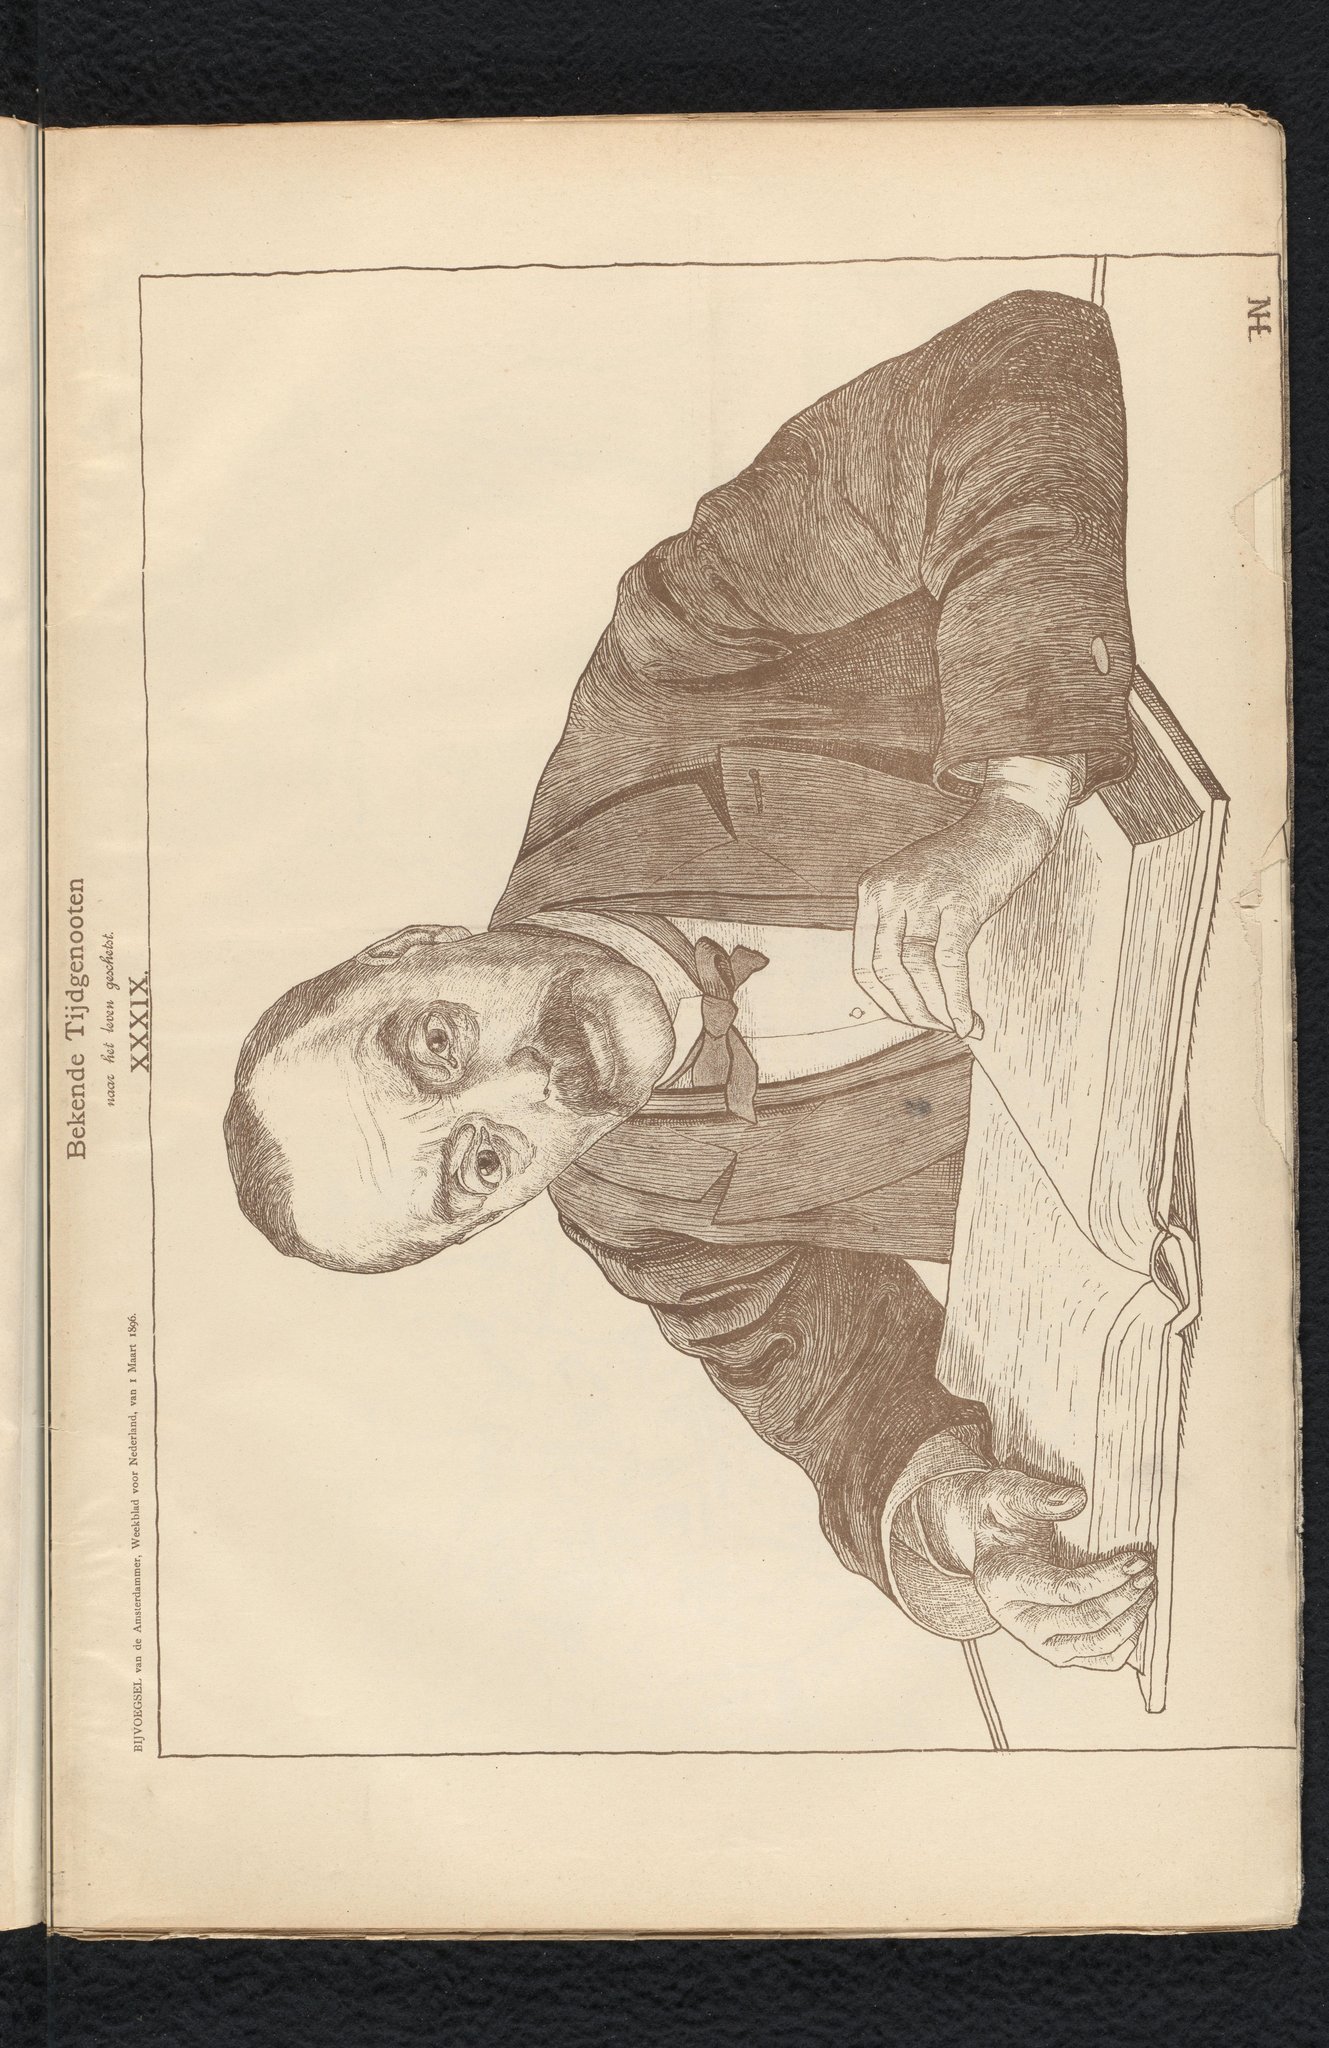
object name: print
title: Bekende Tijdgenooten naar het leven geschetst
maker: ferdinand hart nibbrig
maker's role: draughtsman, painter, print maker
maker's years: 1866-1915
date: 1896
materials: paper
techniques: lithograph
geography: amsterdam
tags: historical persons not known by name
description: Portret van een onbekende man. In de serie 'Bekende Tijdgenooten', nr. XXXIX.